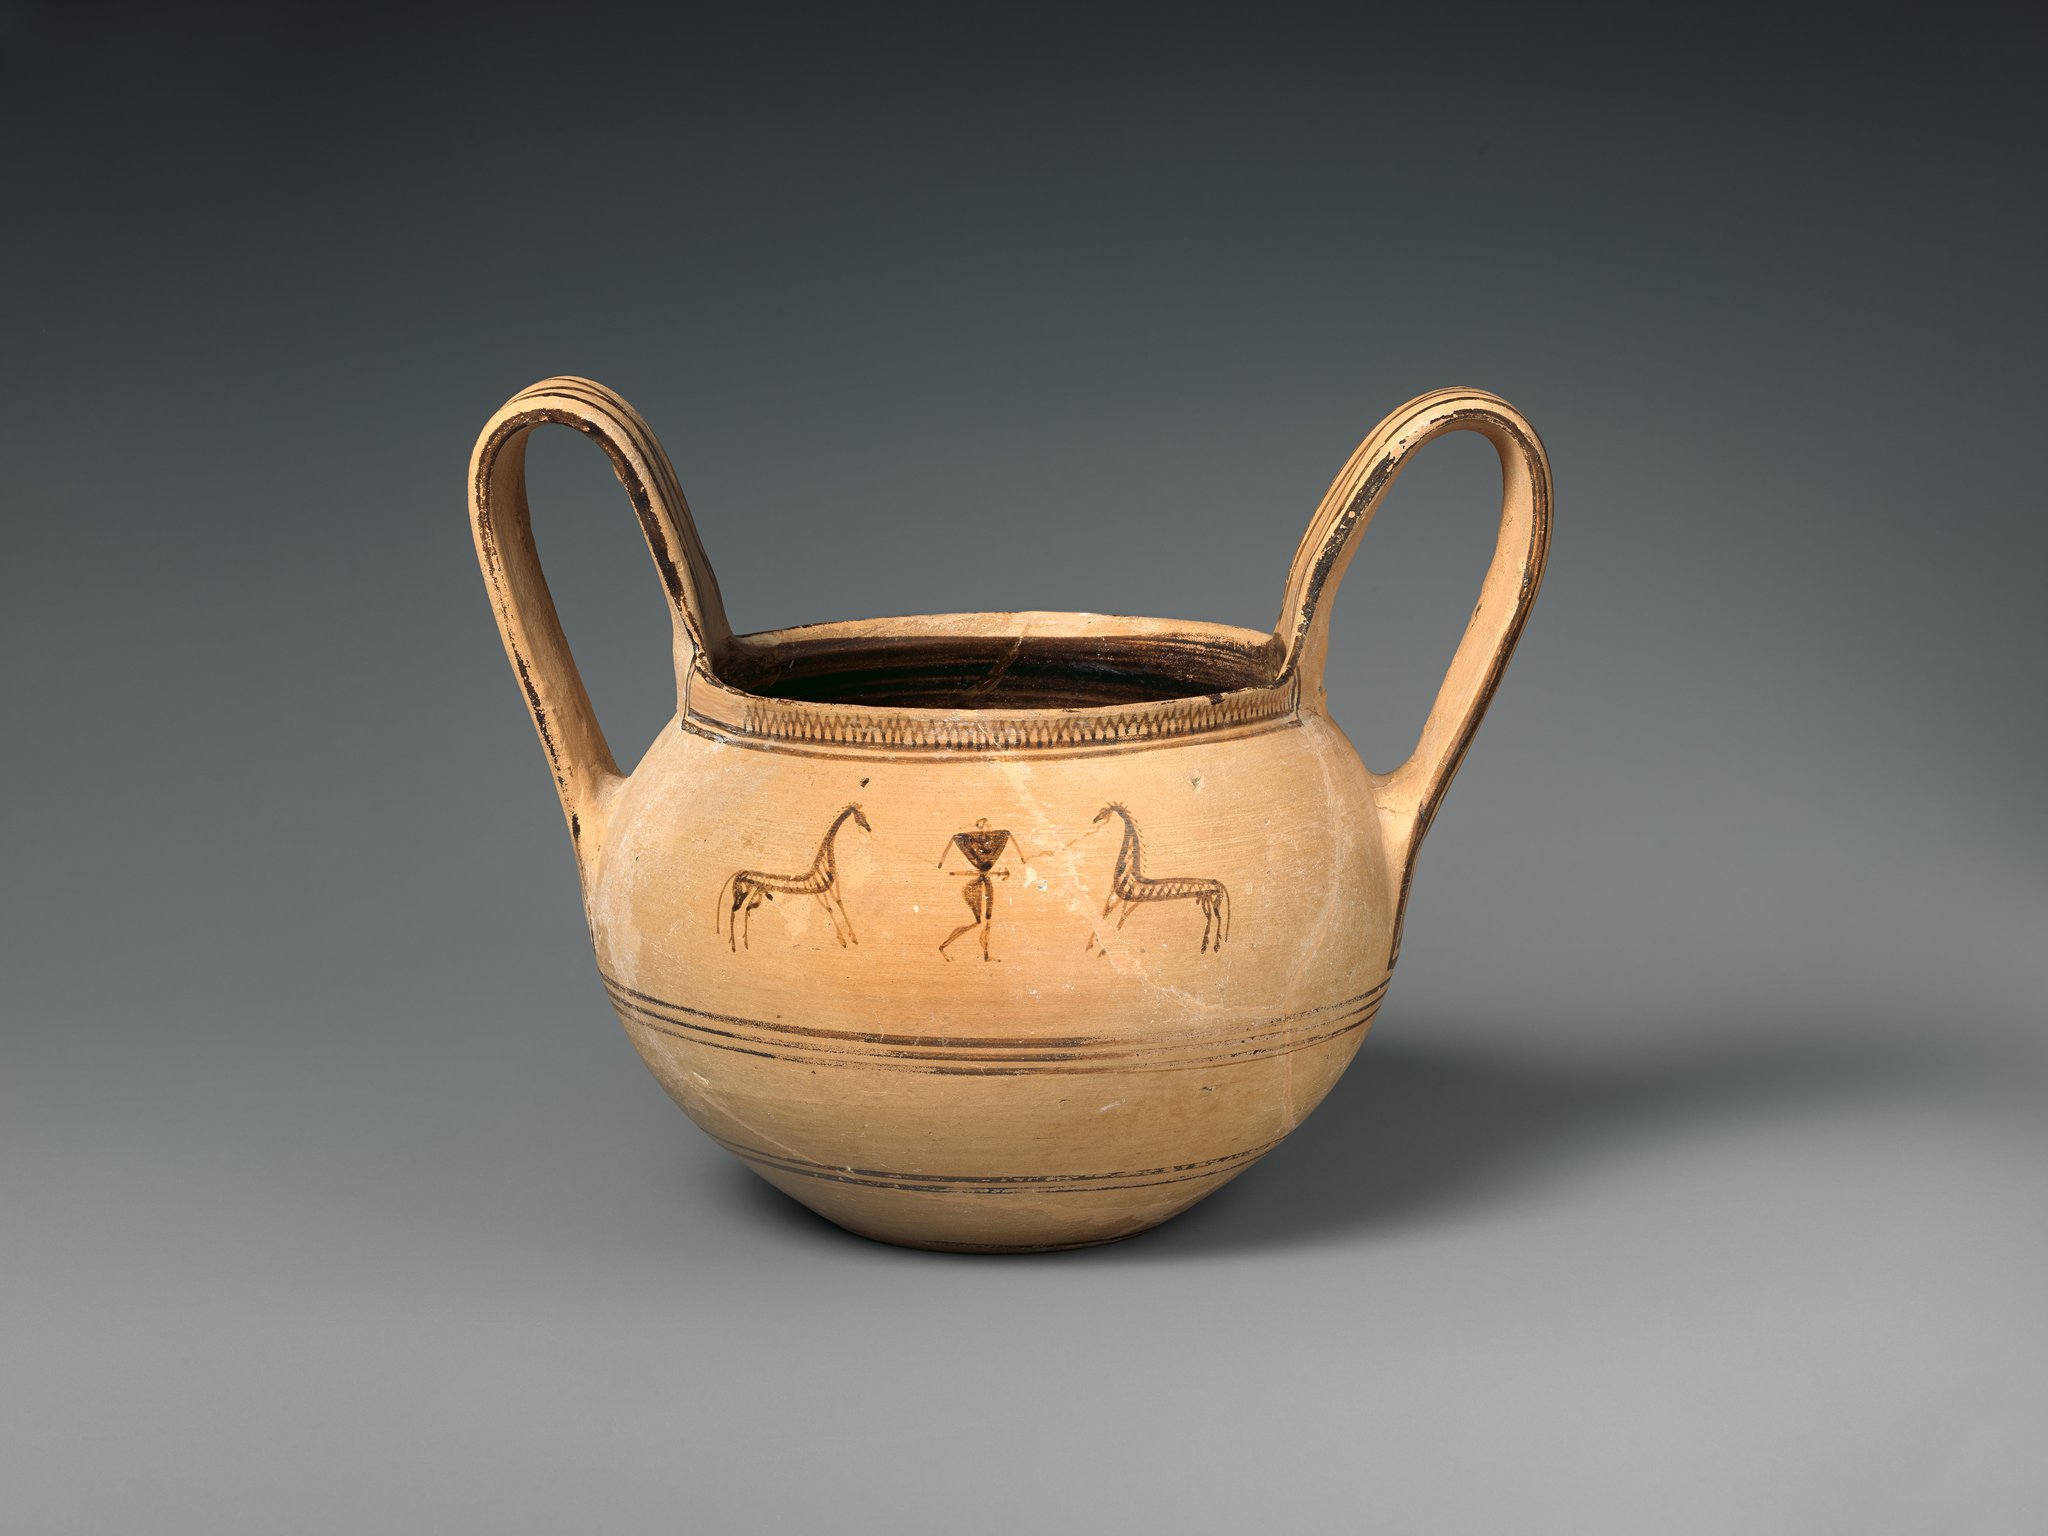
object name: kantharos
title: Terracotta kantharos (drinking cup with two high handles)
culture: greek, attic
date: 734-668 BCE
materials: terracotta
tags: horses